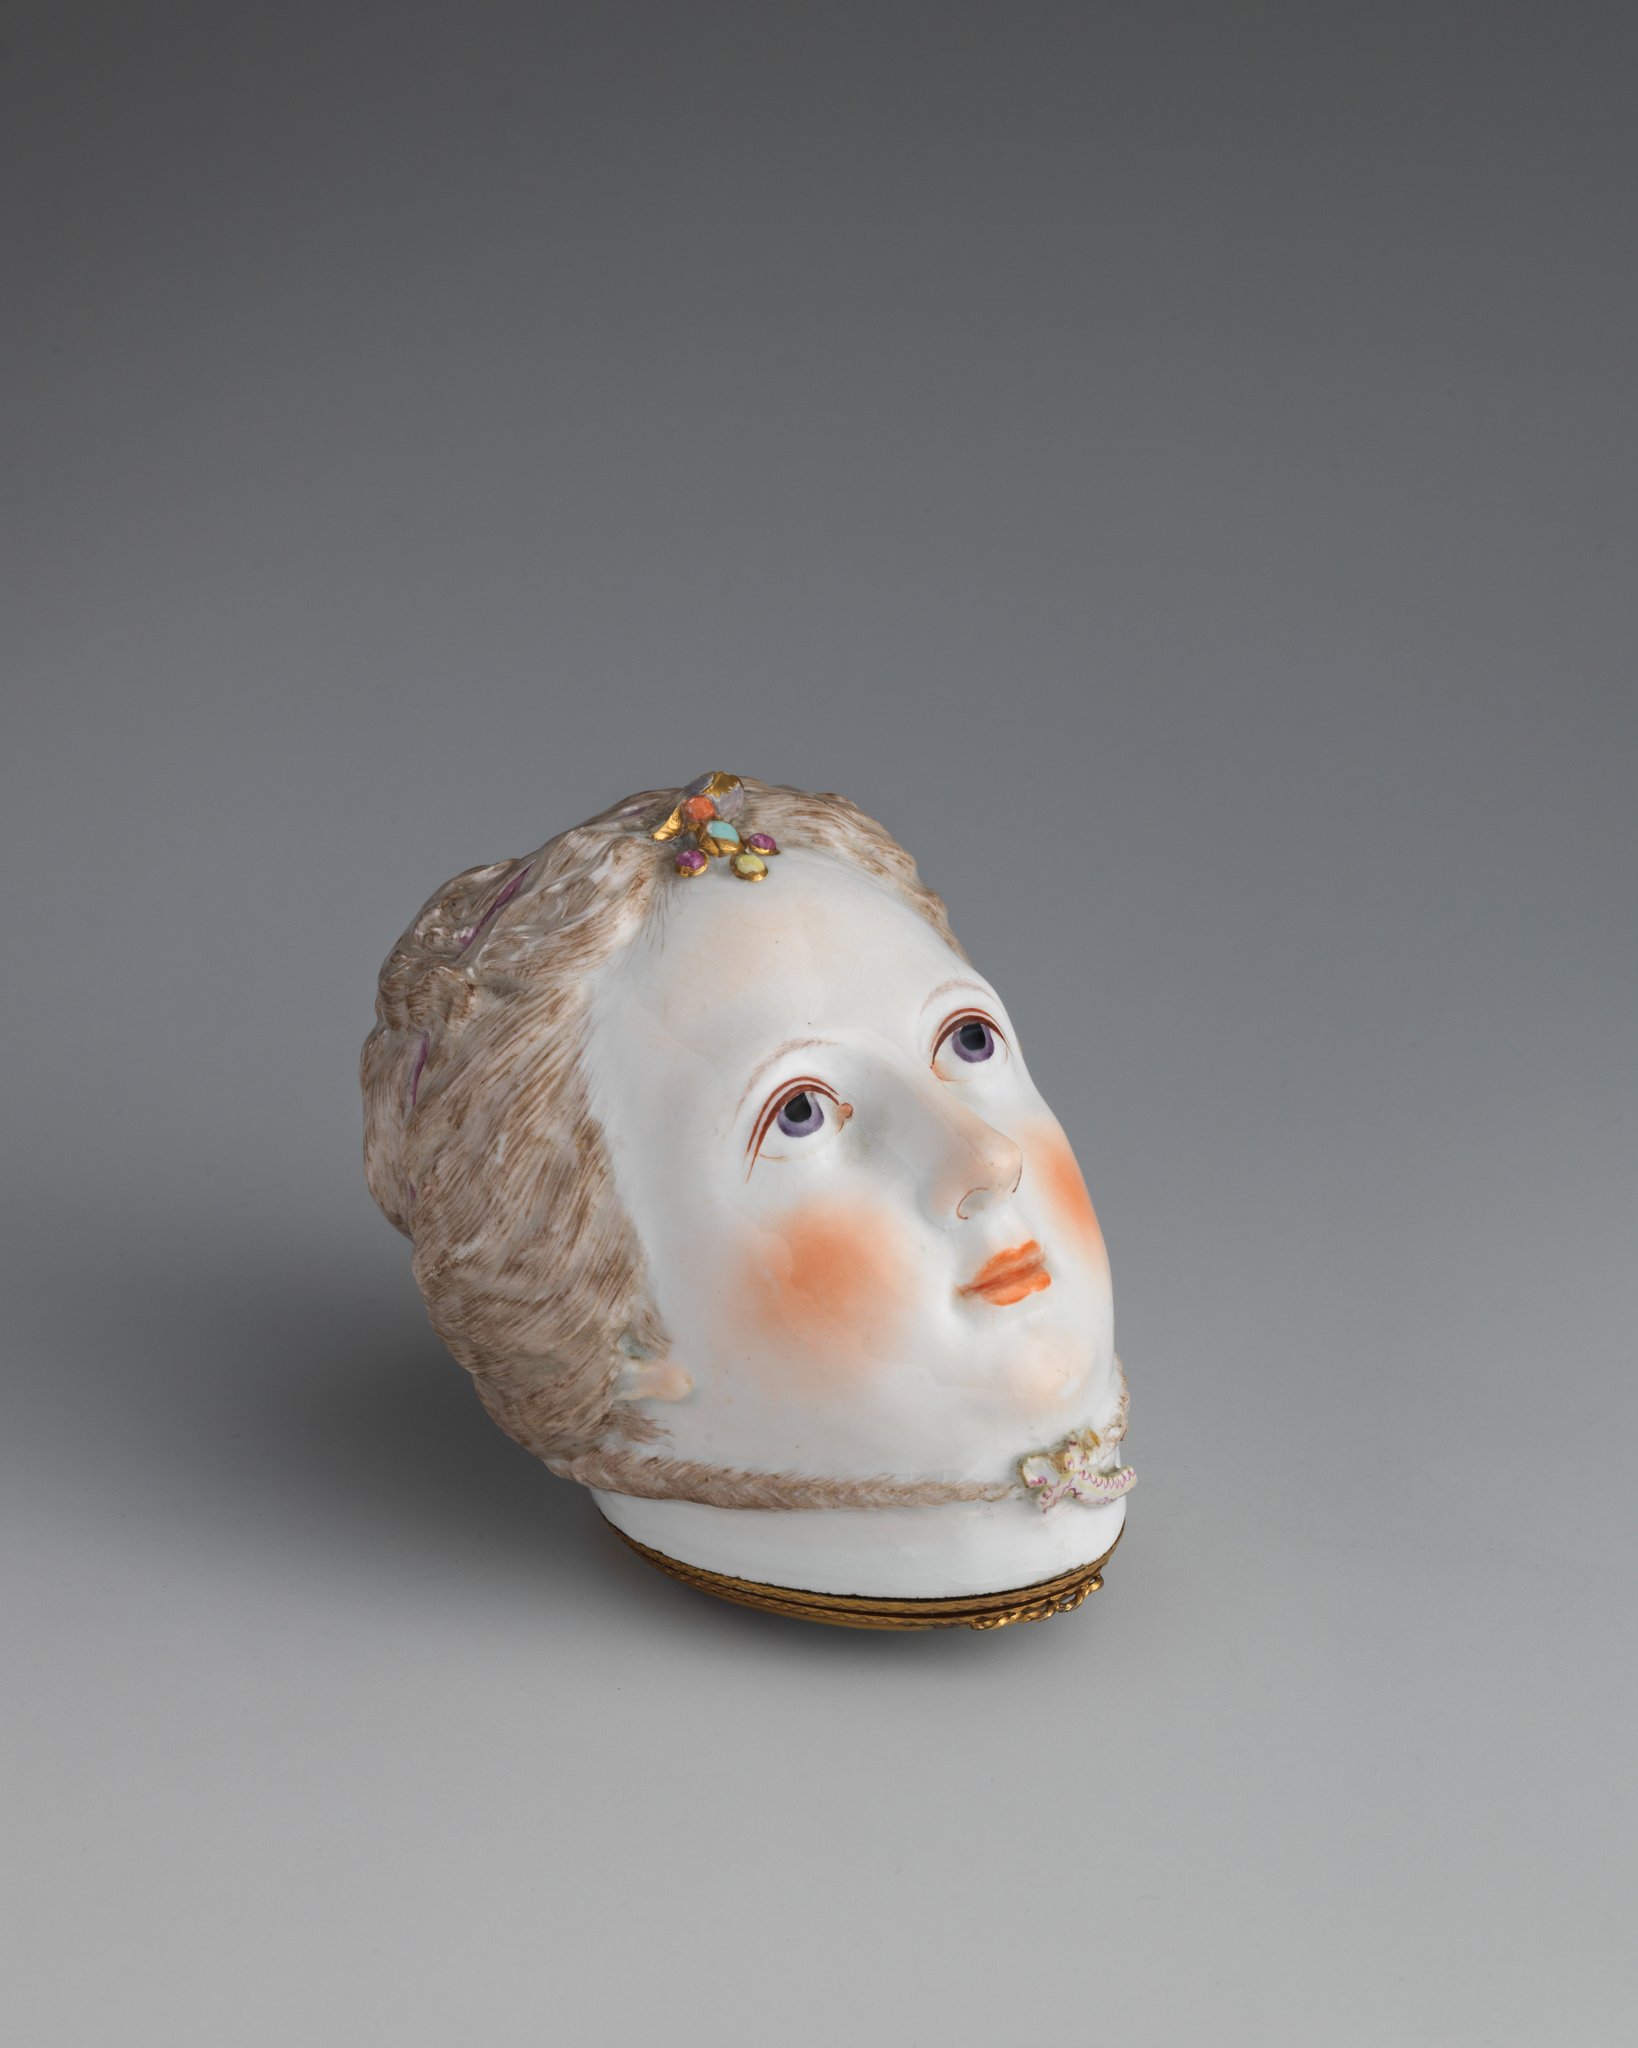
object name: toy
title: Lady's head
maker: chelsea porcelain manufactory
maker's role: factory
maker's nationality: british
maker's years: 1744-1784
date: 1755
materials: soft paste porcelain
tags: faces,heads,women